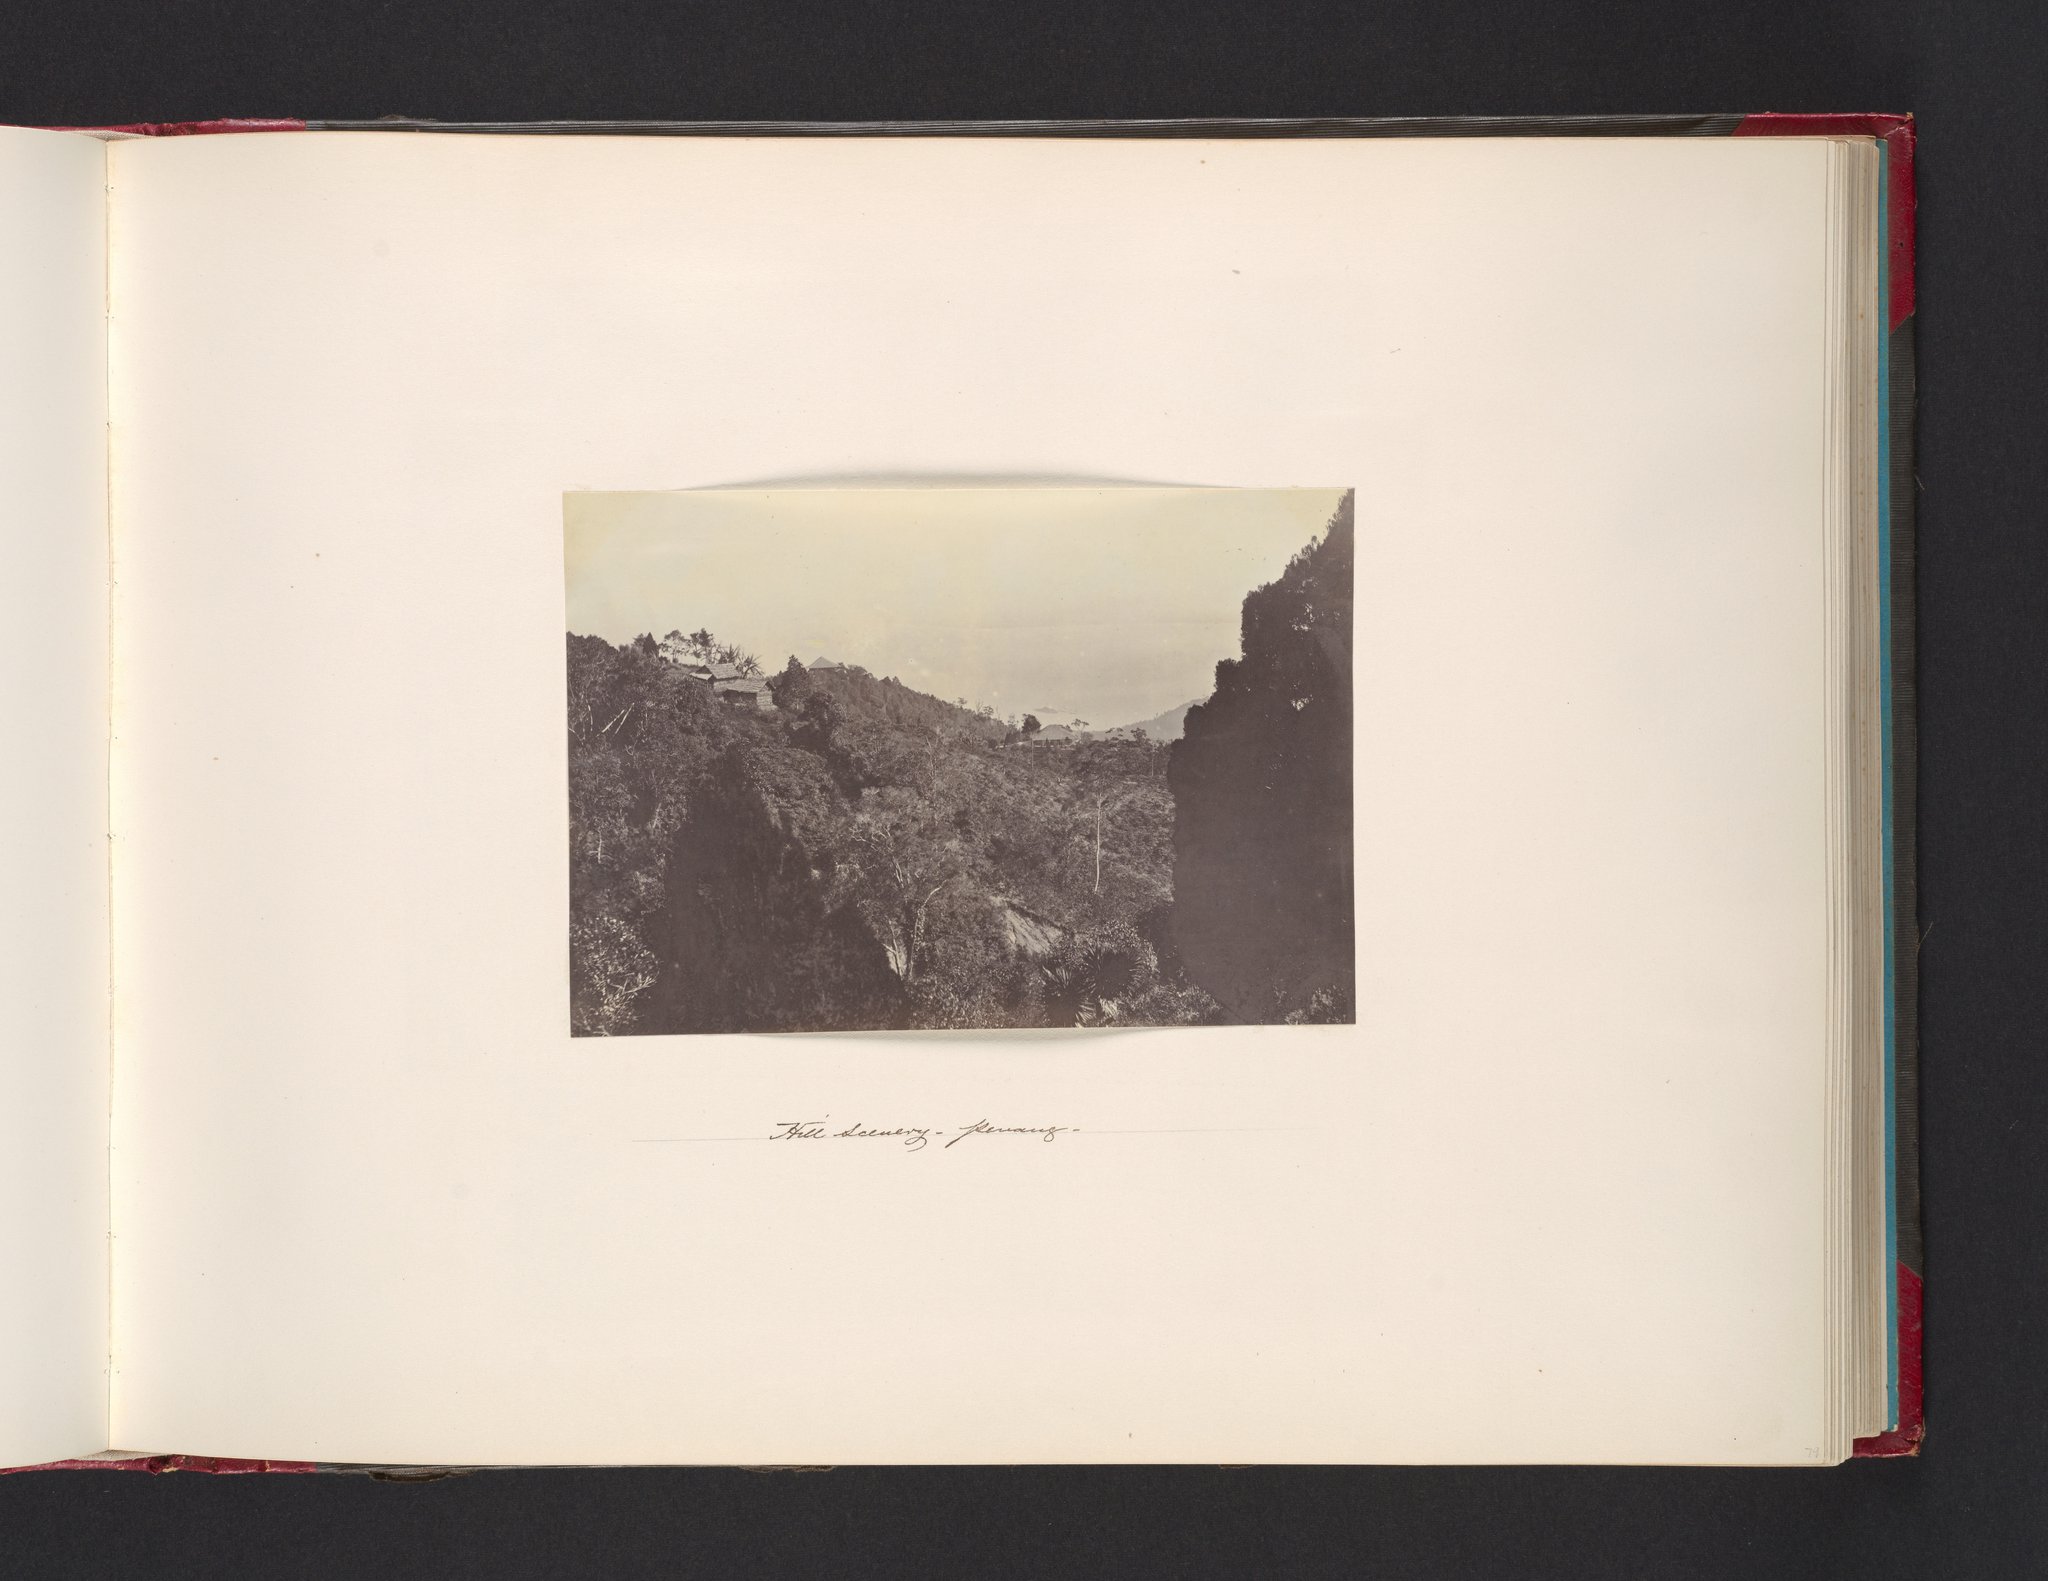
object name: photograph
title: Hill Scenery. Penang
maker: john thomson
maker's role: artist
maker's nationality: british, scottish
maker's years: 1837-1921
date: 1865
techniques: albumen silver print, glass negative